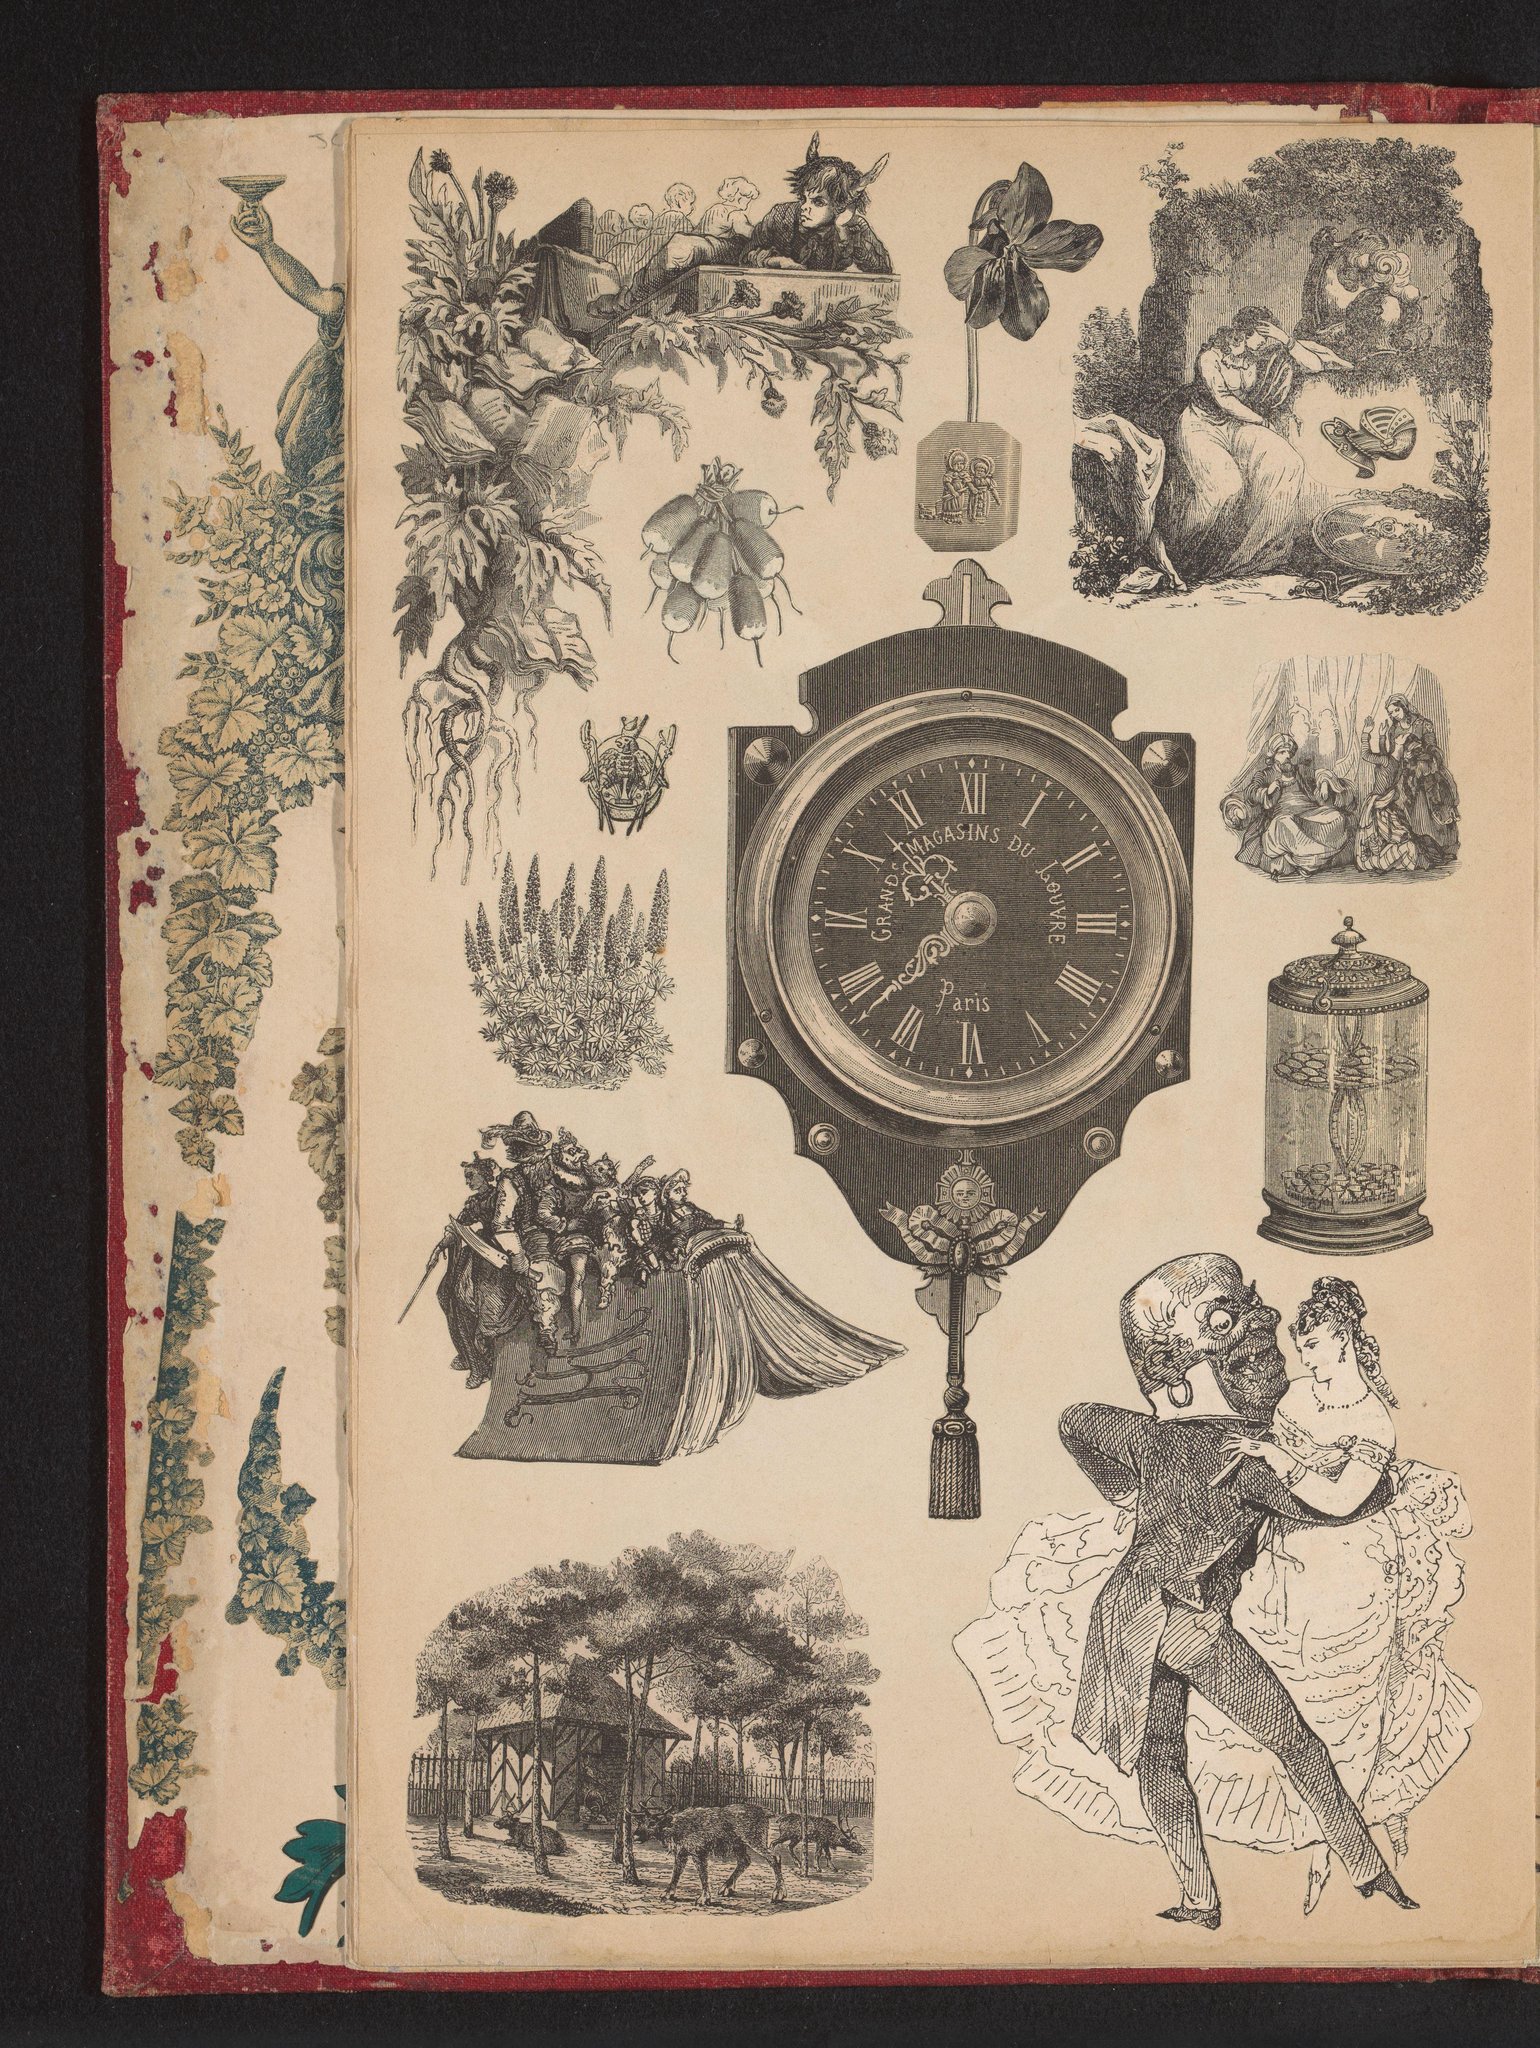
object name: collage visual work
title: Collage van uitgeknipte prenten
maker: Anonymous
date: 1870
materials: paper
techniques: engraving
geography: paris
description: Collage van uitgeknipte prenten. Onderdeel van een album met 18 bladen, aan beide zijden beplakt met uitgeknipte prenten, vermoedelijk afkomstig uit 19e-eeuwse tijdschiften.